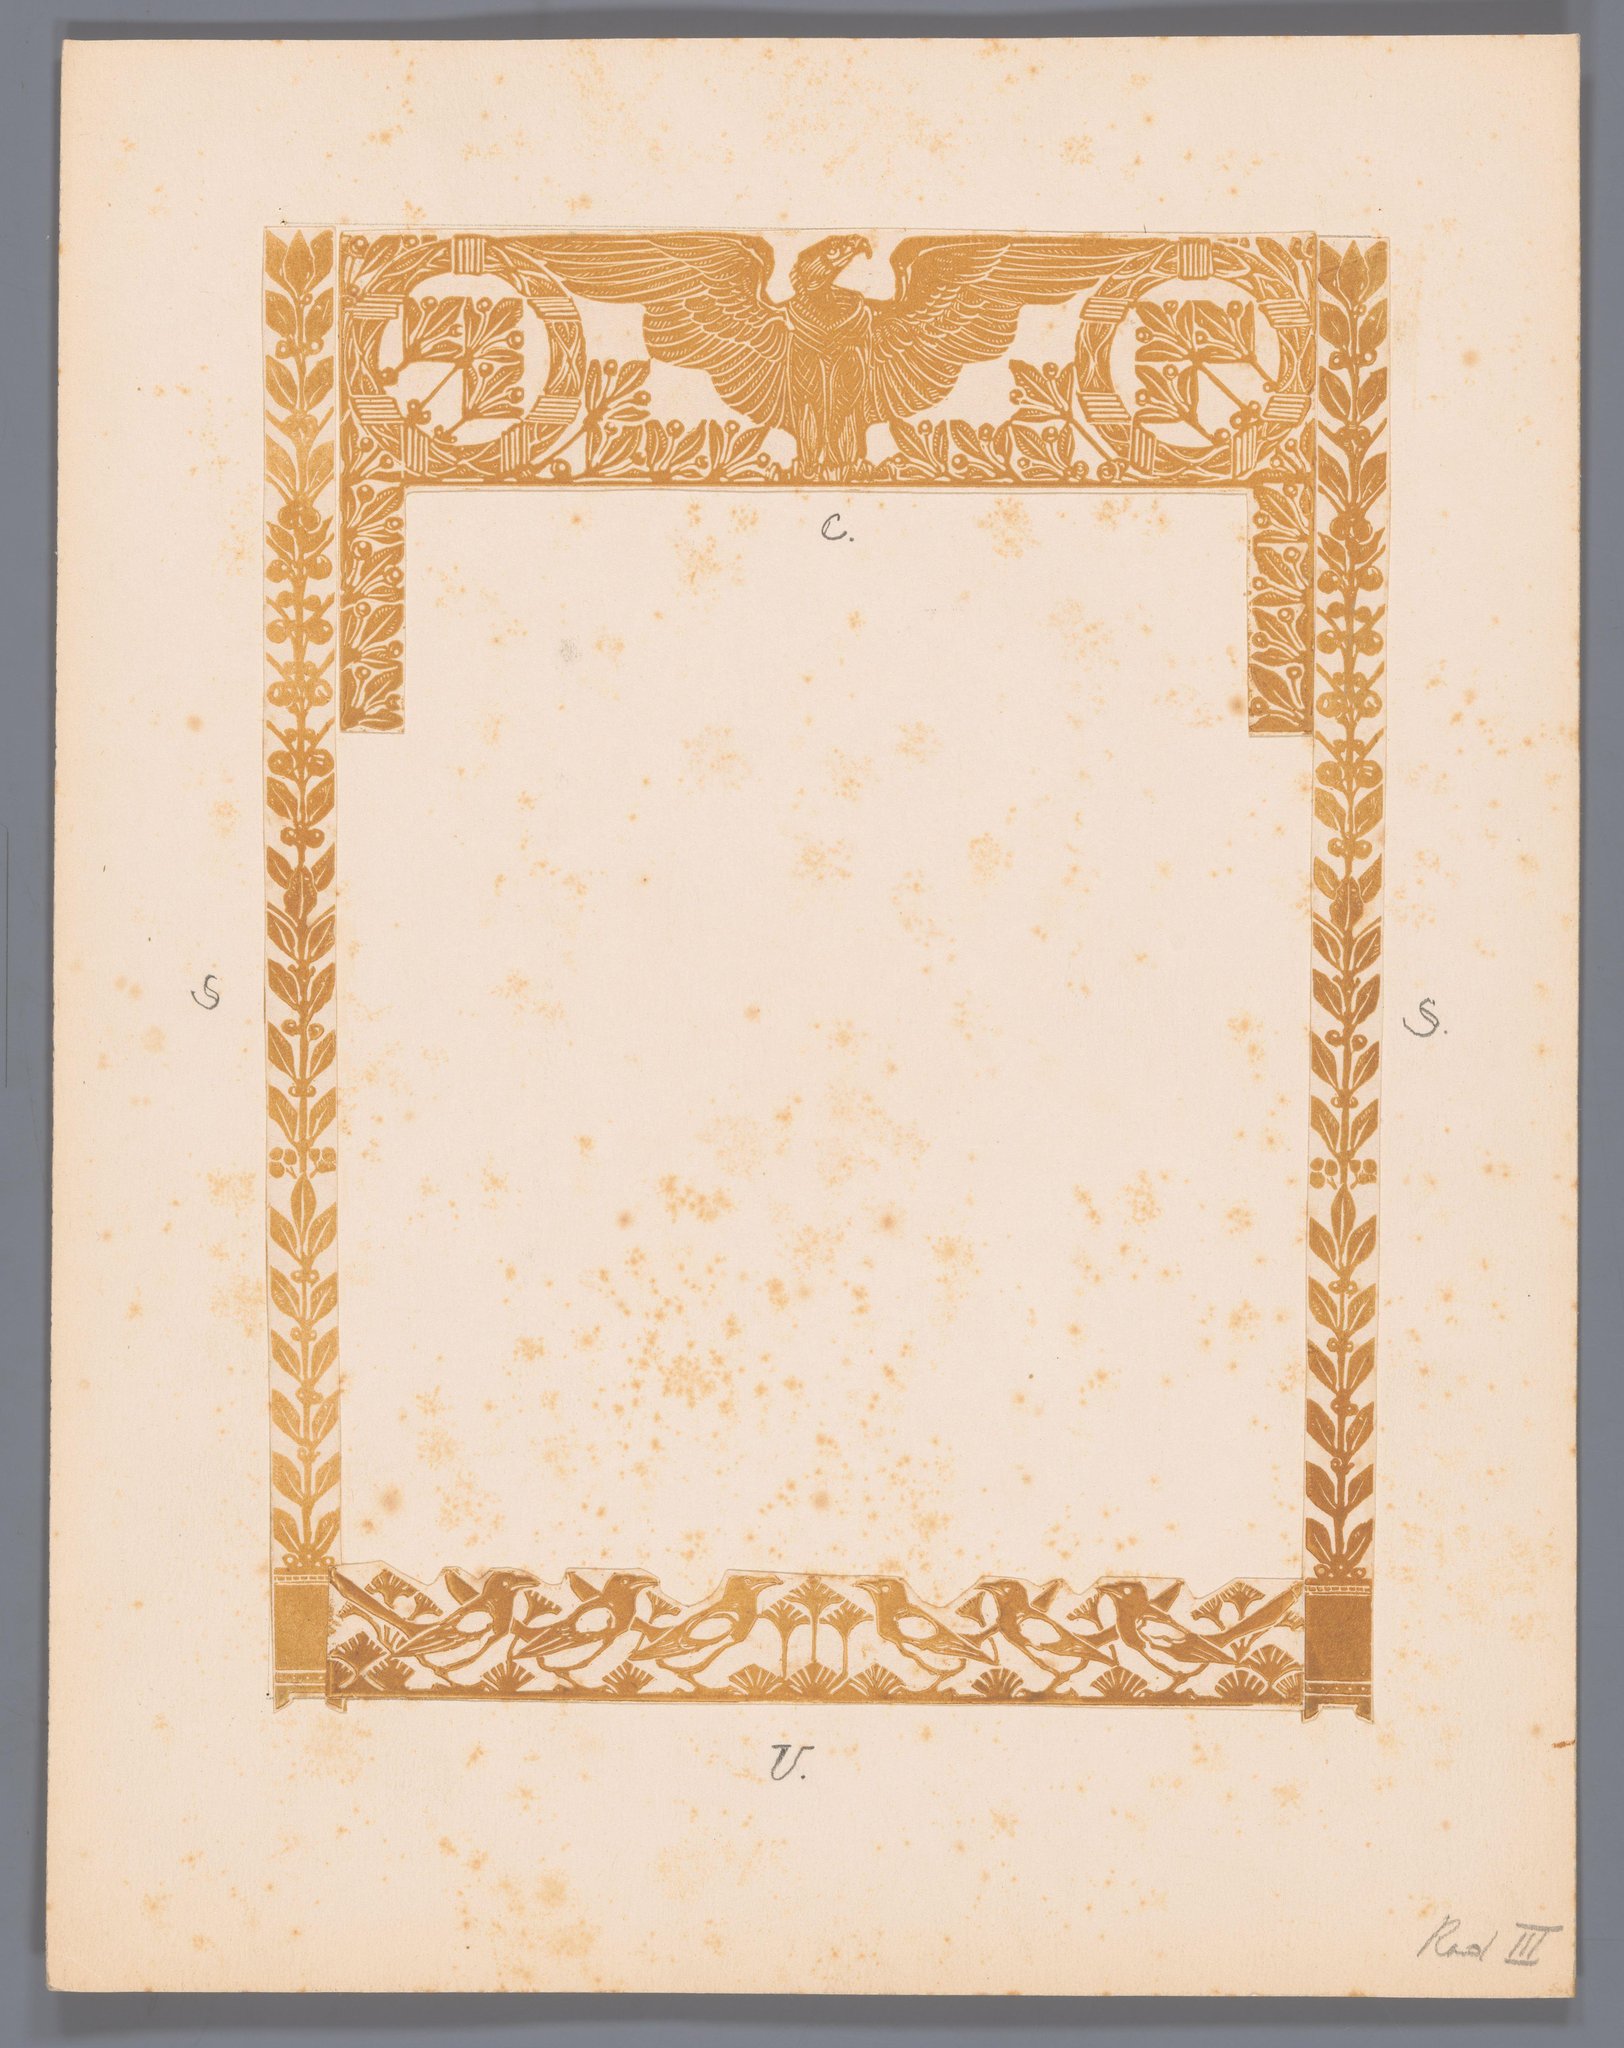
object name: boekillustratie ontwerp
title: Proefdruk voor pagina uit Reinaert de Vos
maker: bernard willem wierink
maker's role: draughtsman, print maker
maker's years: 1856-1939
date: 1910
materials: paper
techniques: relief print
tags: fable of reynard the fox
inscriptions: collector's mark: Lugt 2228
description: Ontwerp voor: Streuvels, Stijn (Frank Lateur). Reinaert de Vos naar verschillende uitgaven van het middeleeuwsche epos. Amsterdam: L.J. Veen, 1910. Deze prent is vermoedelijk een plaatsnede, ook al wordt in de literatuur veelal gesproken over een houtsnede. Voor zover Wierink zijn prenten in hoogdruk zelf nader heeft omschreven, heeft hij altijd de term 'plaatsnede' gebruikt.